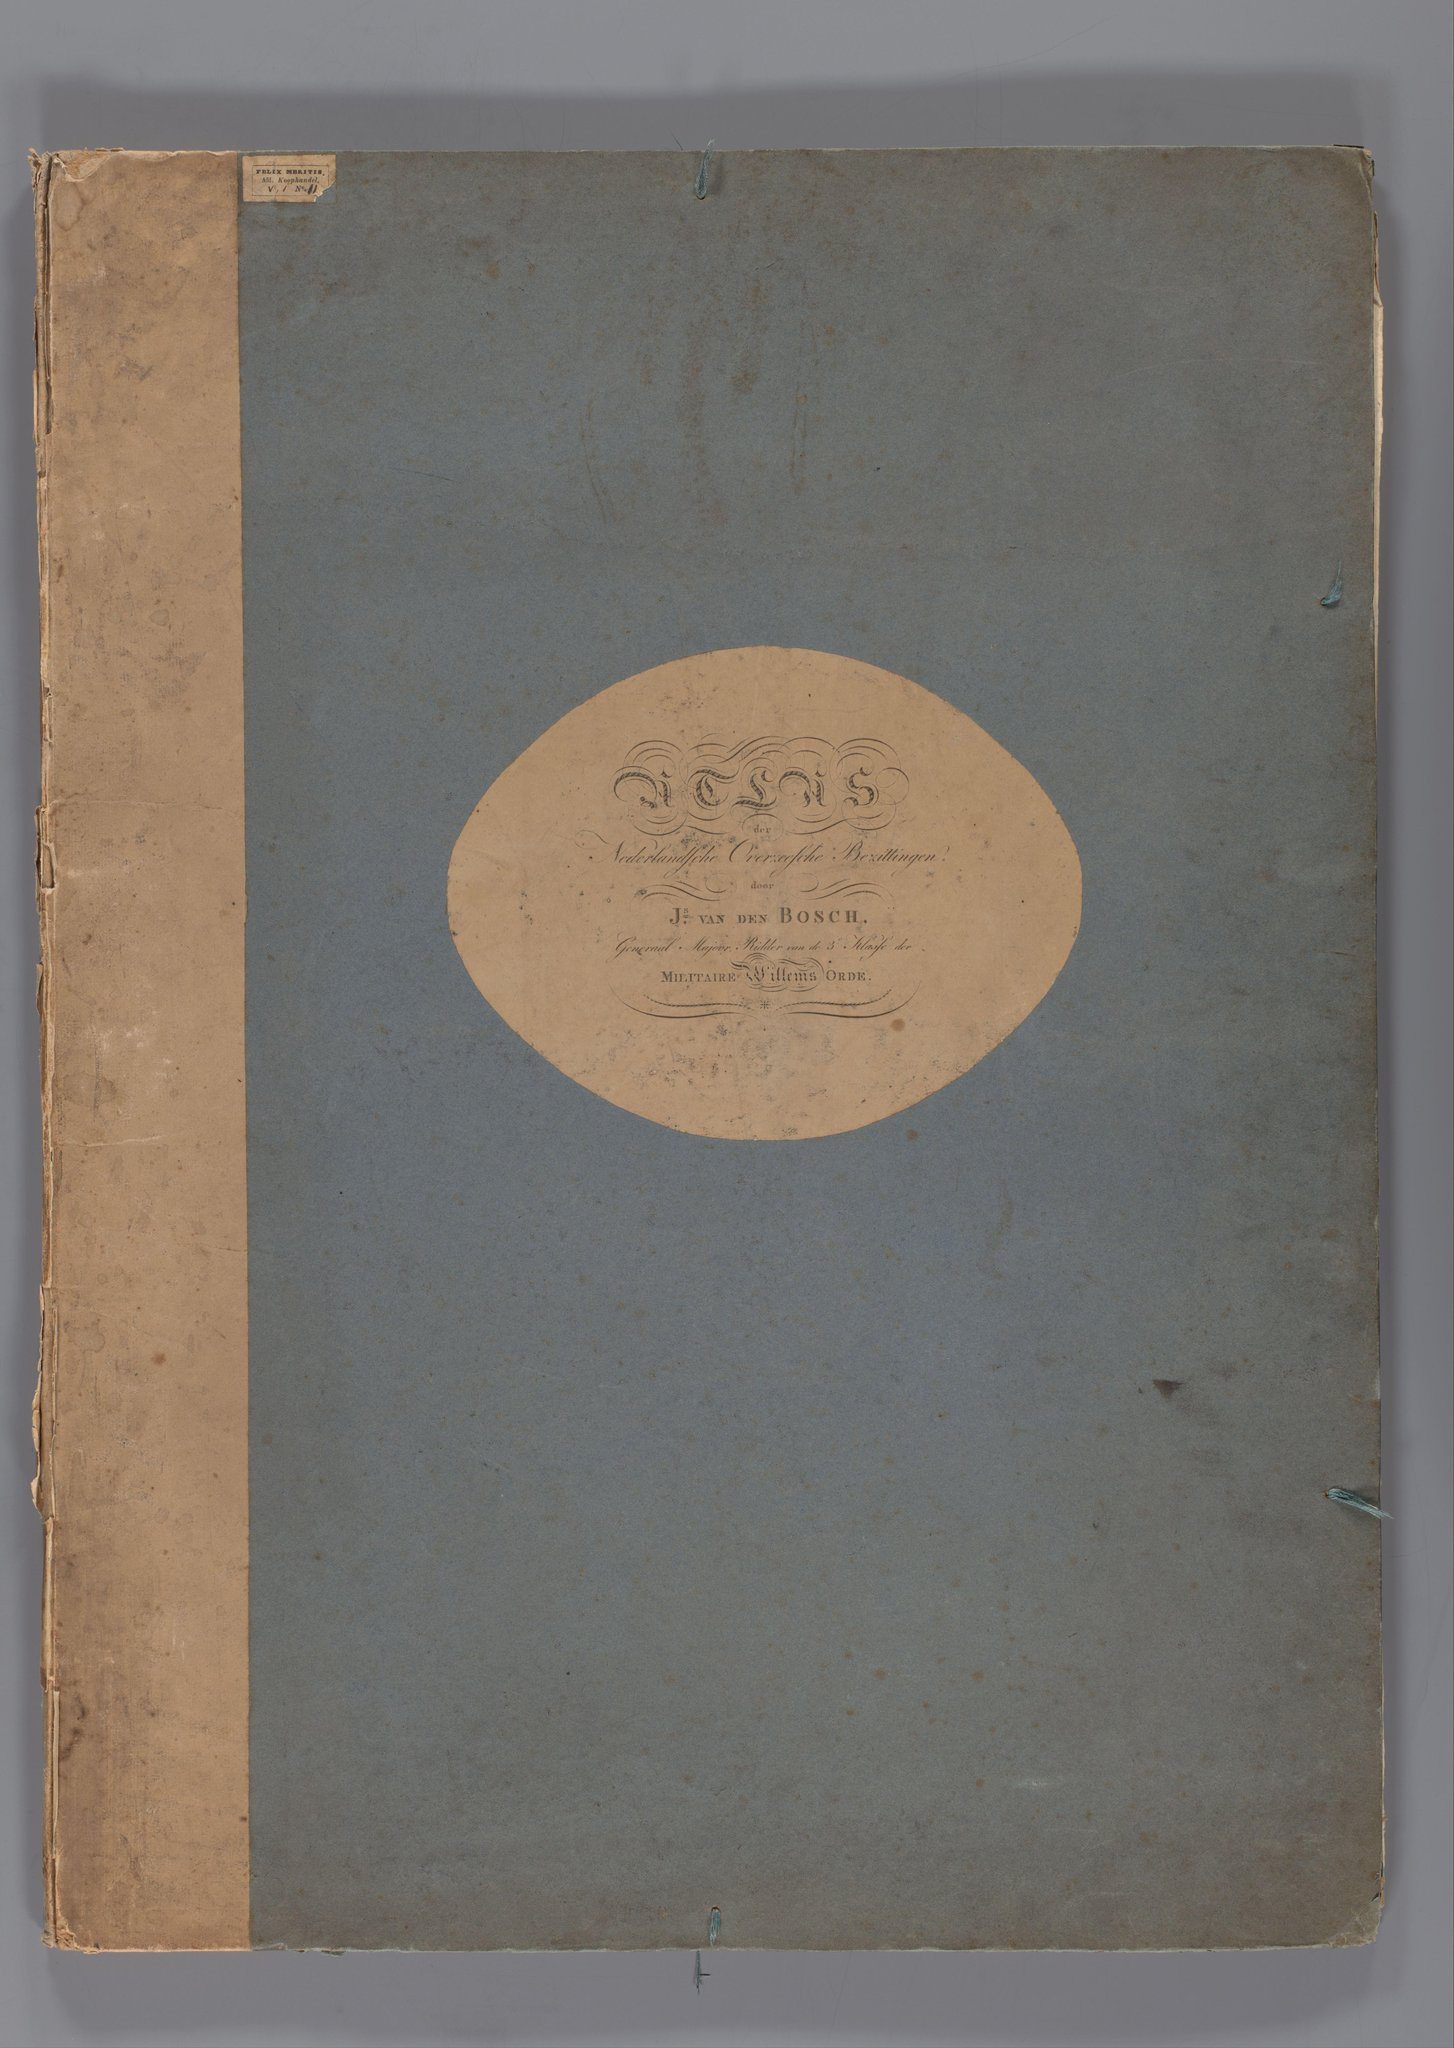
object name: wrapper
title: Omslag voor: Js. van den Bosch, Atlas der Nederlandsche overzeesche bezittingen, 1818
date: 1818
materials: cardboard, paper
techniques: bookbinding, engraving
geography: the hague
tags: maps, atlases, dutch east indies, the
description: Omslag voor: Bosch, Js. van den. Atlas der overzeesche bezittingen van Zijne Majesteit den Koning der Nederlanden, aan hoogst denzelven opgedragen. Den Haag en Amsterdam: Gebroeders van Cleef, 1818. Mogelijk is alle tekst in deze uitgave gegraveerd door Jan Gerritsz. Visser, naar kalligrafie van Landegent. Dit staat echter alleen vermeld op de titelpagina (NG-936-1) en op de laatste kaart (NG-936-13).